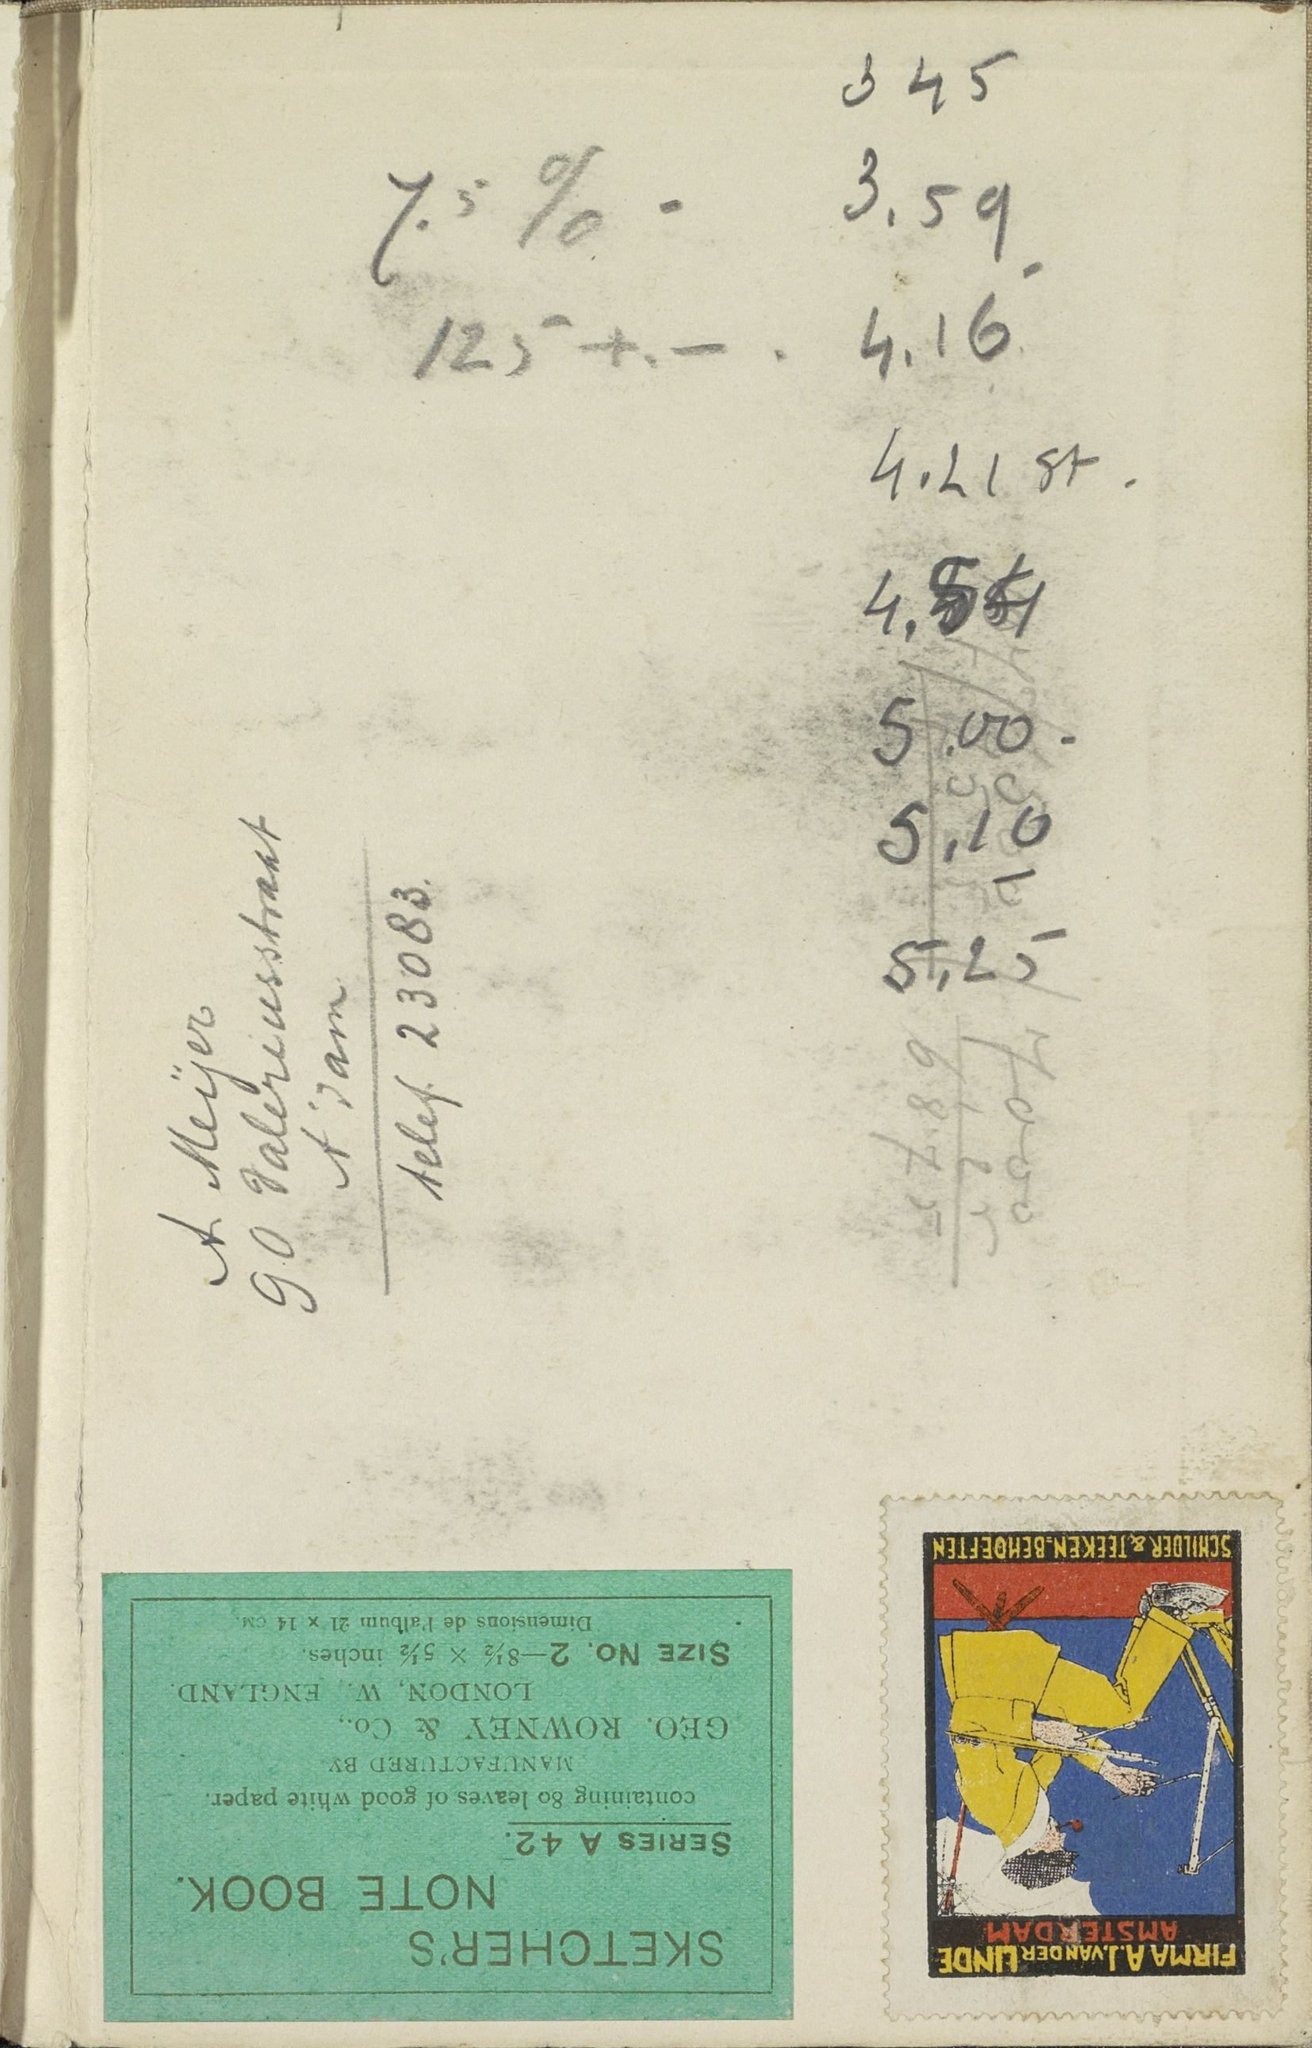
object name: endleaf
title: Notities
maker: cornelis vreedenburgh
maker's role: draughtsman, print maker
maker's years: 1880-1946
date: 1890-1946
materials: paper, pencil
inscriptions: annotation: ‘A Meijer/ 90 Valeriusstraat/ A'dam/ telef 23083/ [...]’, retailer's mark: ‘FIRMA A.J. van der LINE/ AMSTERDAM/ SCHILDER &TEEKEN BEHOEFTEN’, factory mark: ‘SKETCHER'S/ NOTE BOOK/ SERIES A 42/ containing 80 leaves of good white paper./ MANUFACTURED BY/ GEO. ROWNEY & CO., LONDON, W., ENGLAND/ SIZE No. 2- 8 1/2 x 5 1/2 inches./ Dimensions de l'album 21 x 14 cm.’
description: Achterste schutblad uit een schetsboek met met 50 bladen.